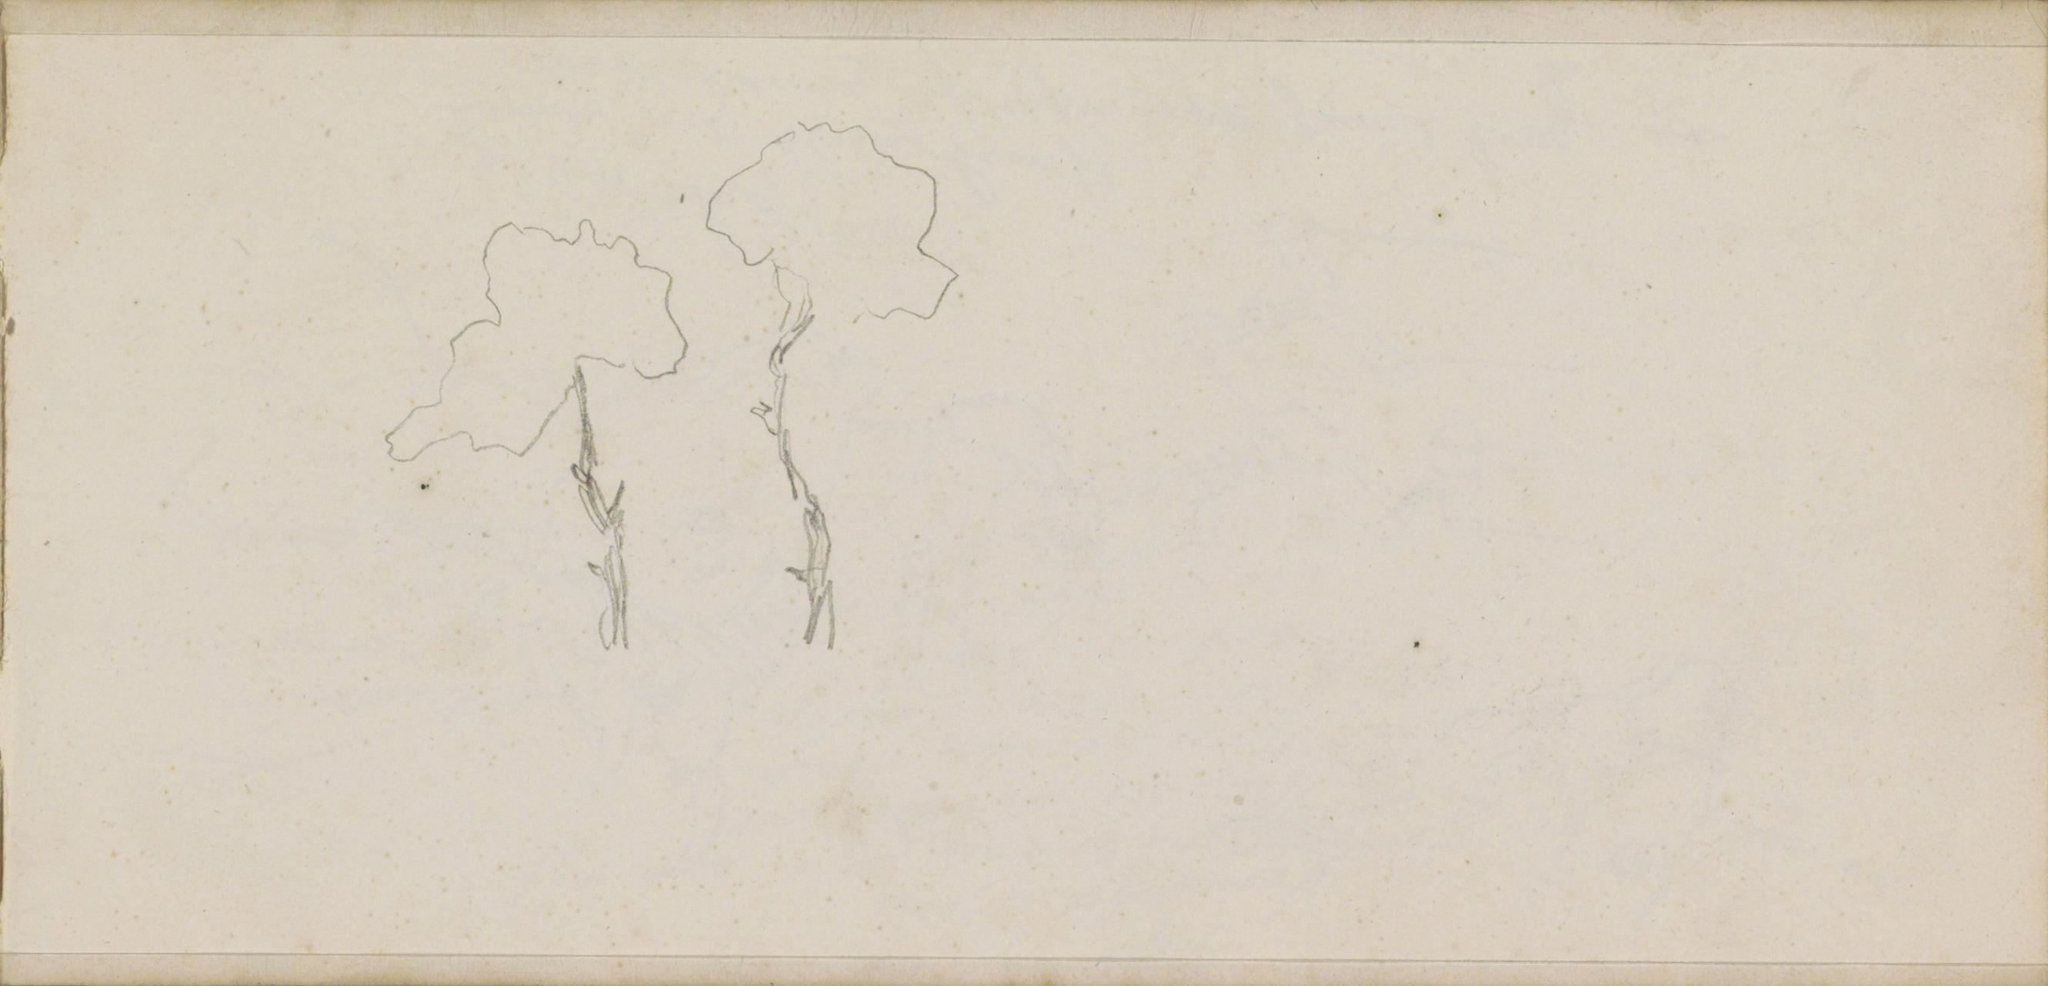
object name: sketchbook leaf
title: Twee bomen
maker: johannes tavenraat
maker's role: draughtsman, painter, print maker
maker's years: 1809-1881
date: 1840-1868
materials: paper, pencil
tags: trees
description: Blad 47 recto uit een schetsboek met 63 bladen.